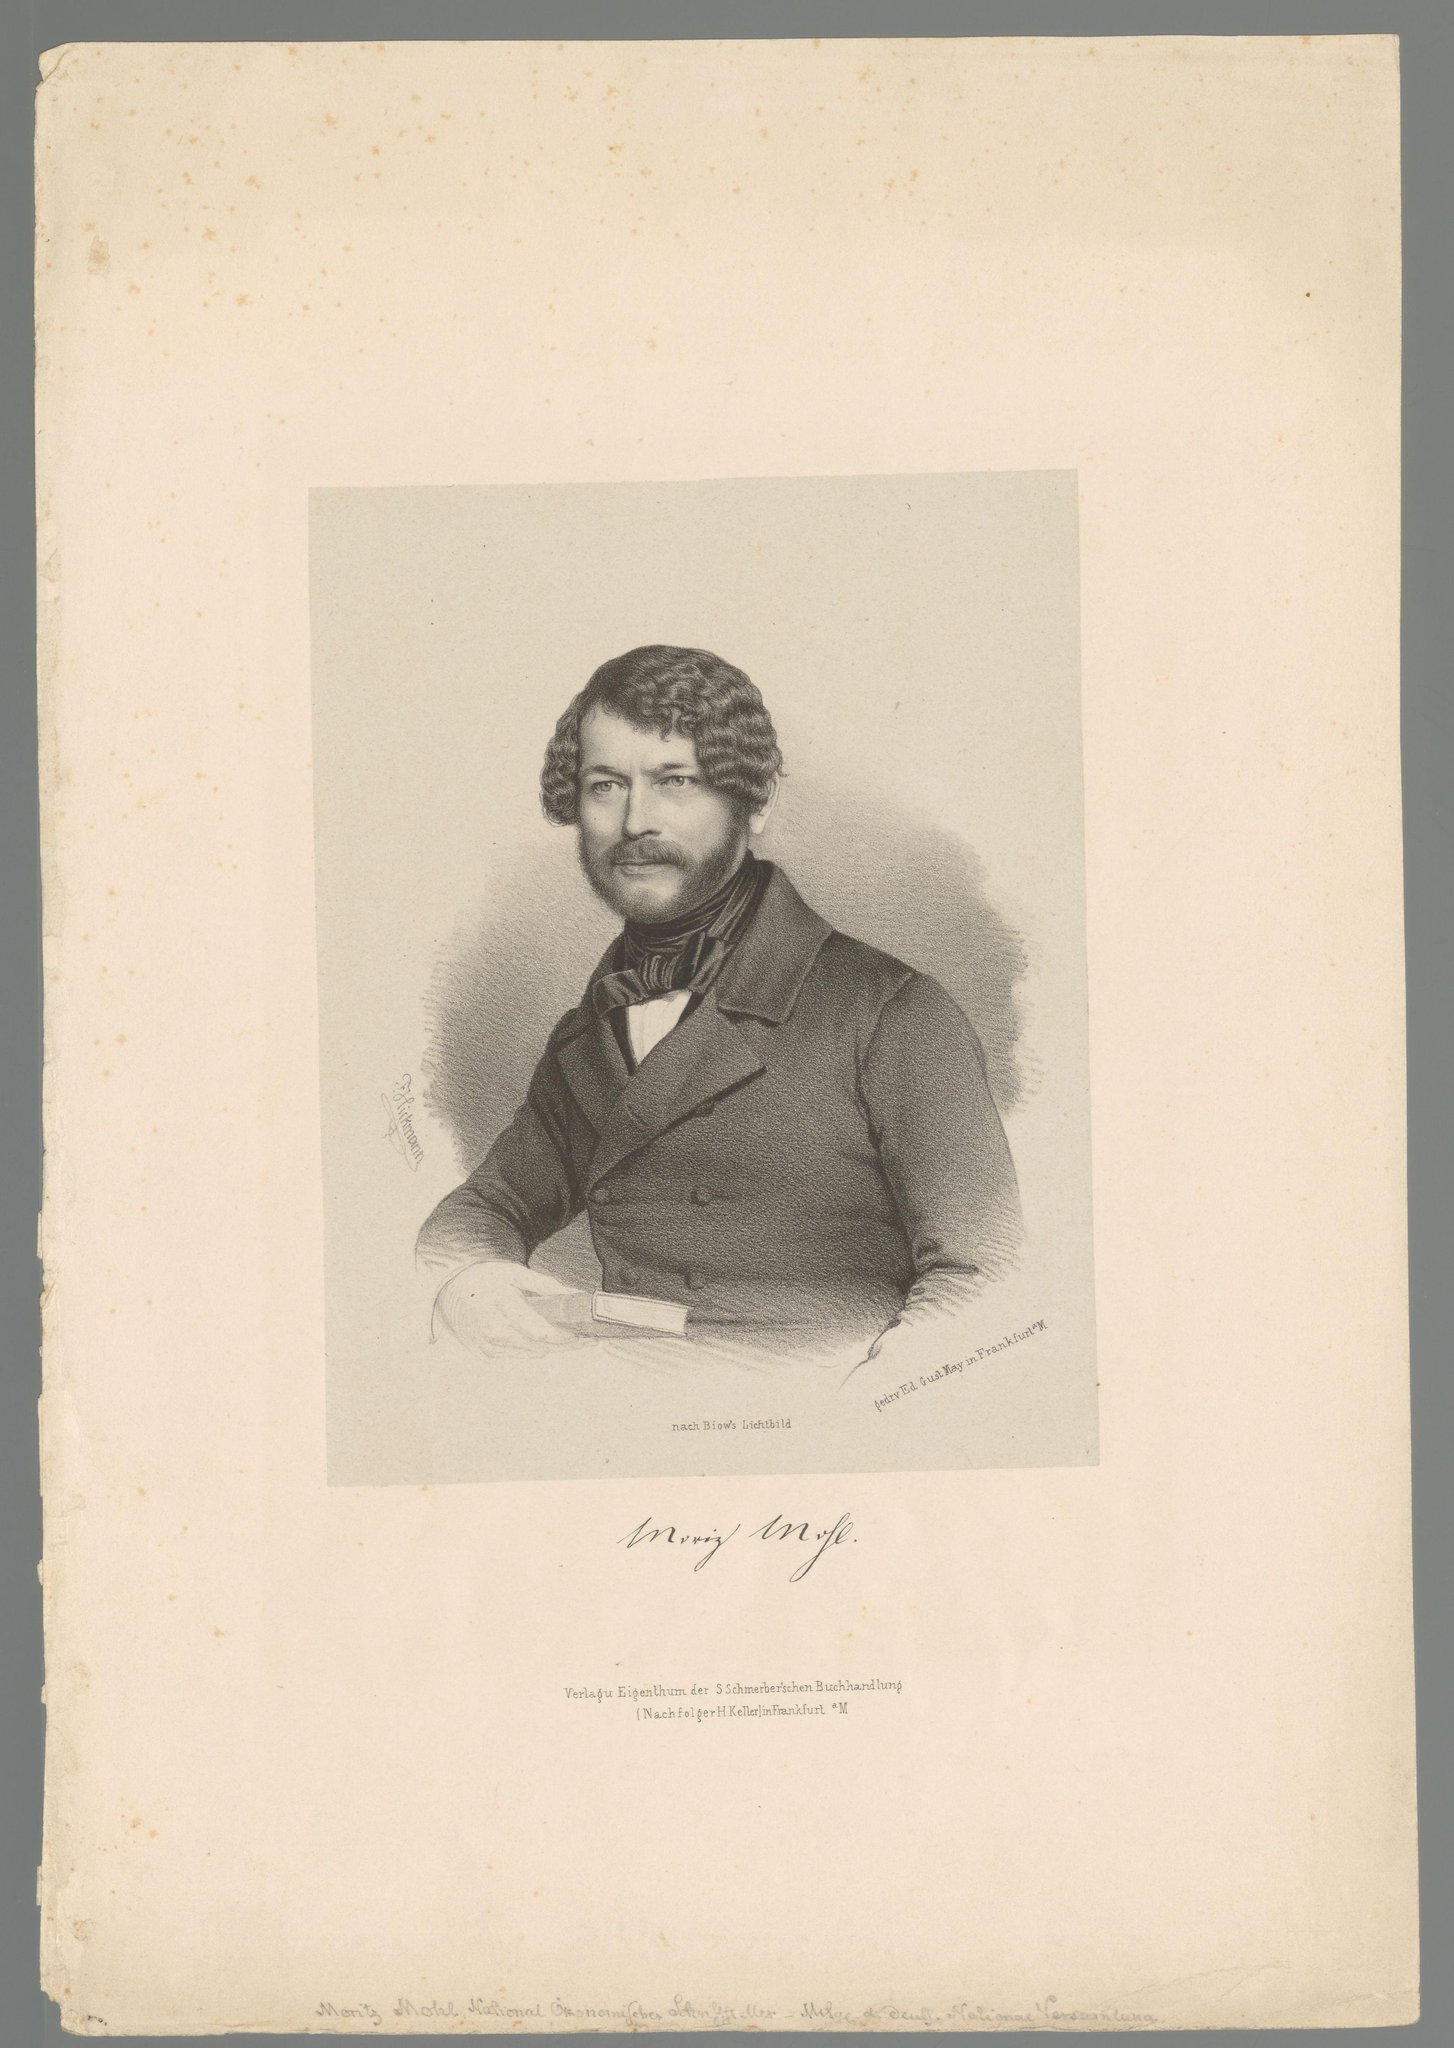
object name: print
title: Portret van Moritz Mohl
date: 1830-1900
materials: paper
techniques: lithograph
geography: frankfurt am main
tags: politician, historical persons, politician, e.g. party leader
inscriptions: collector's mark: Lugt 2228